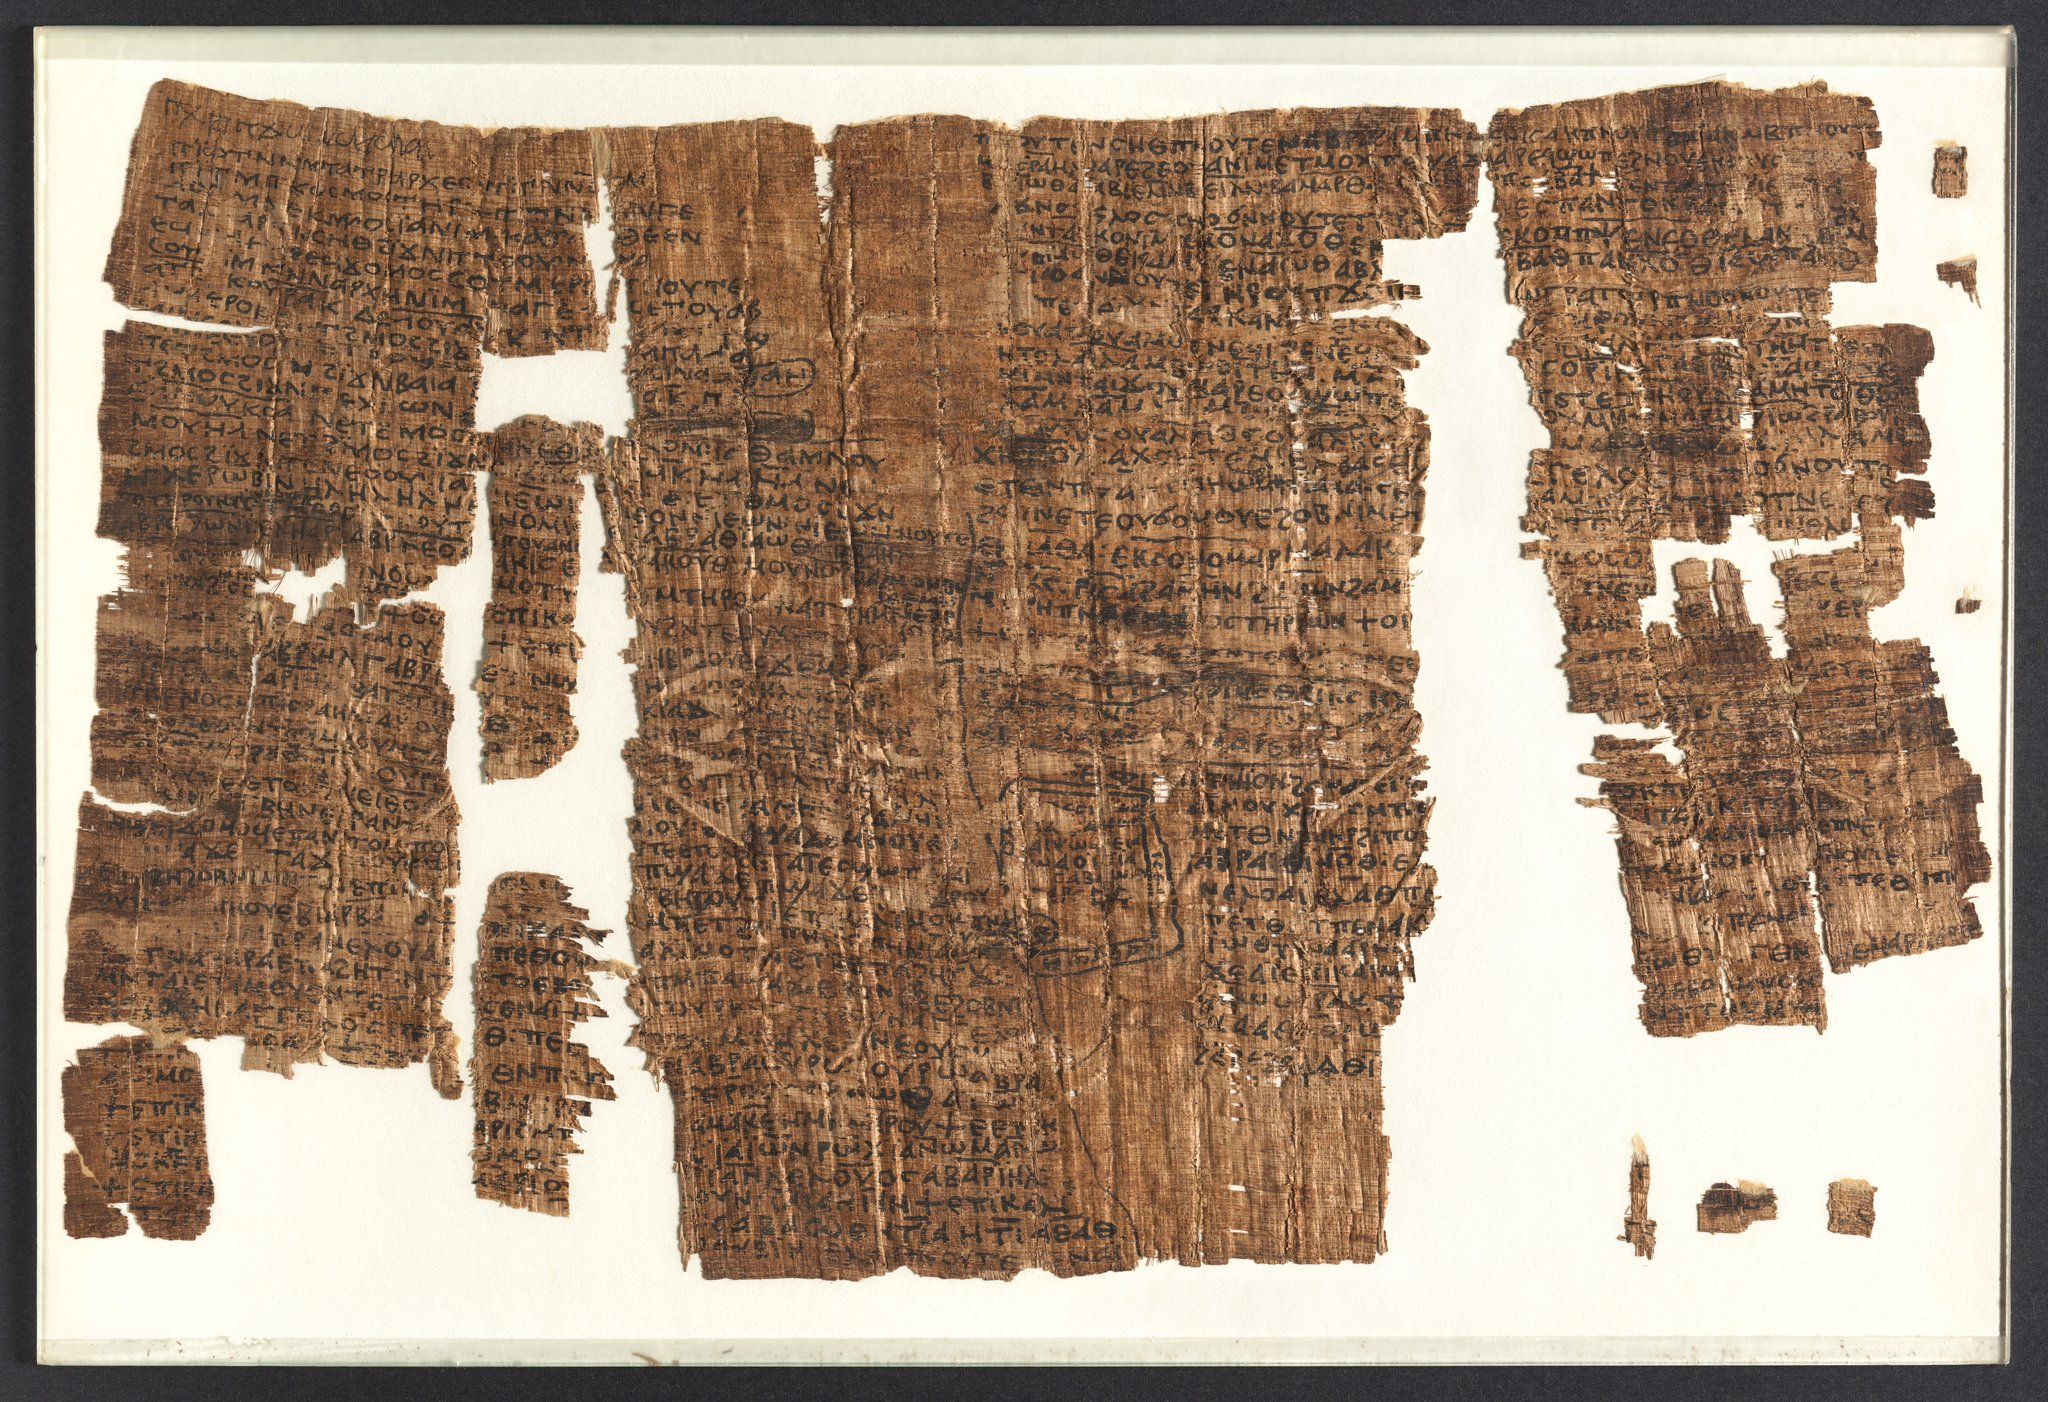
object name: papyrus fragment with seth on mount sinai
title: Papyrus Fragments with Seth on Mount Sinai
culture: coptic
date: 401-600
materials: ink, papyrus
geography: egypt